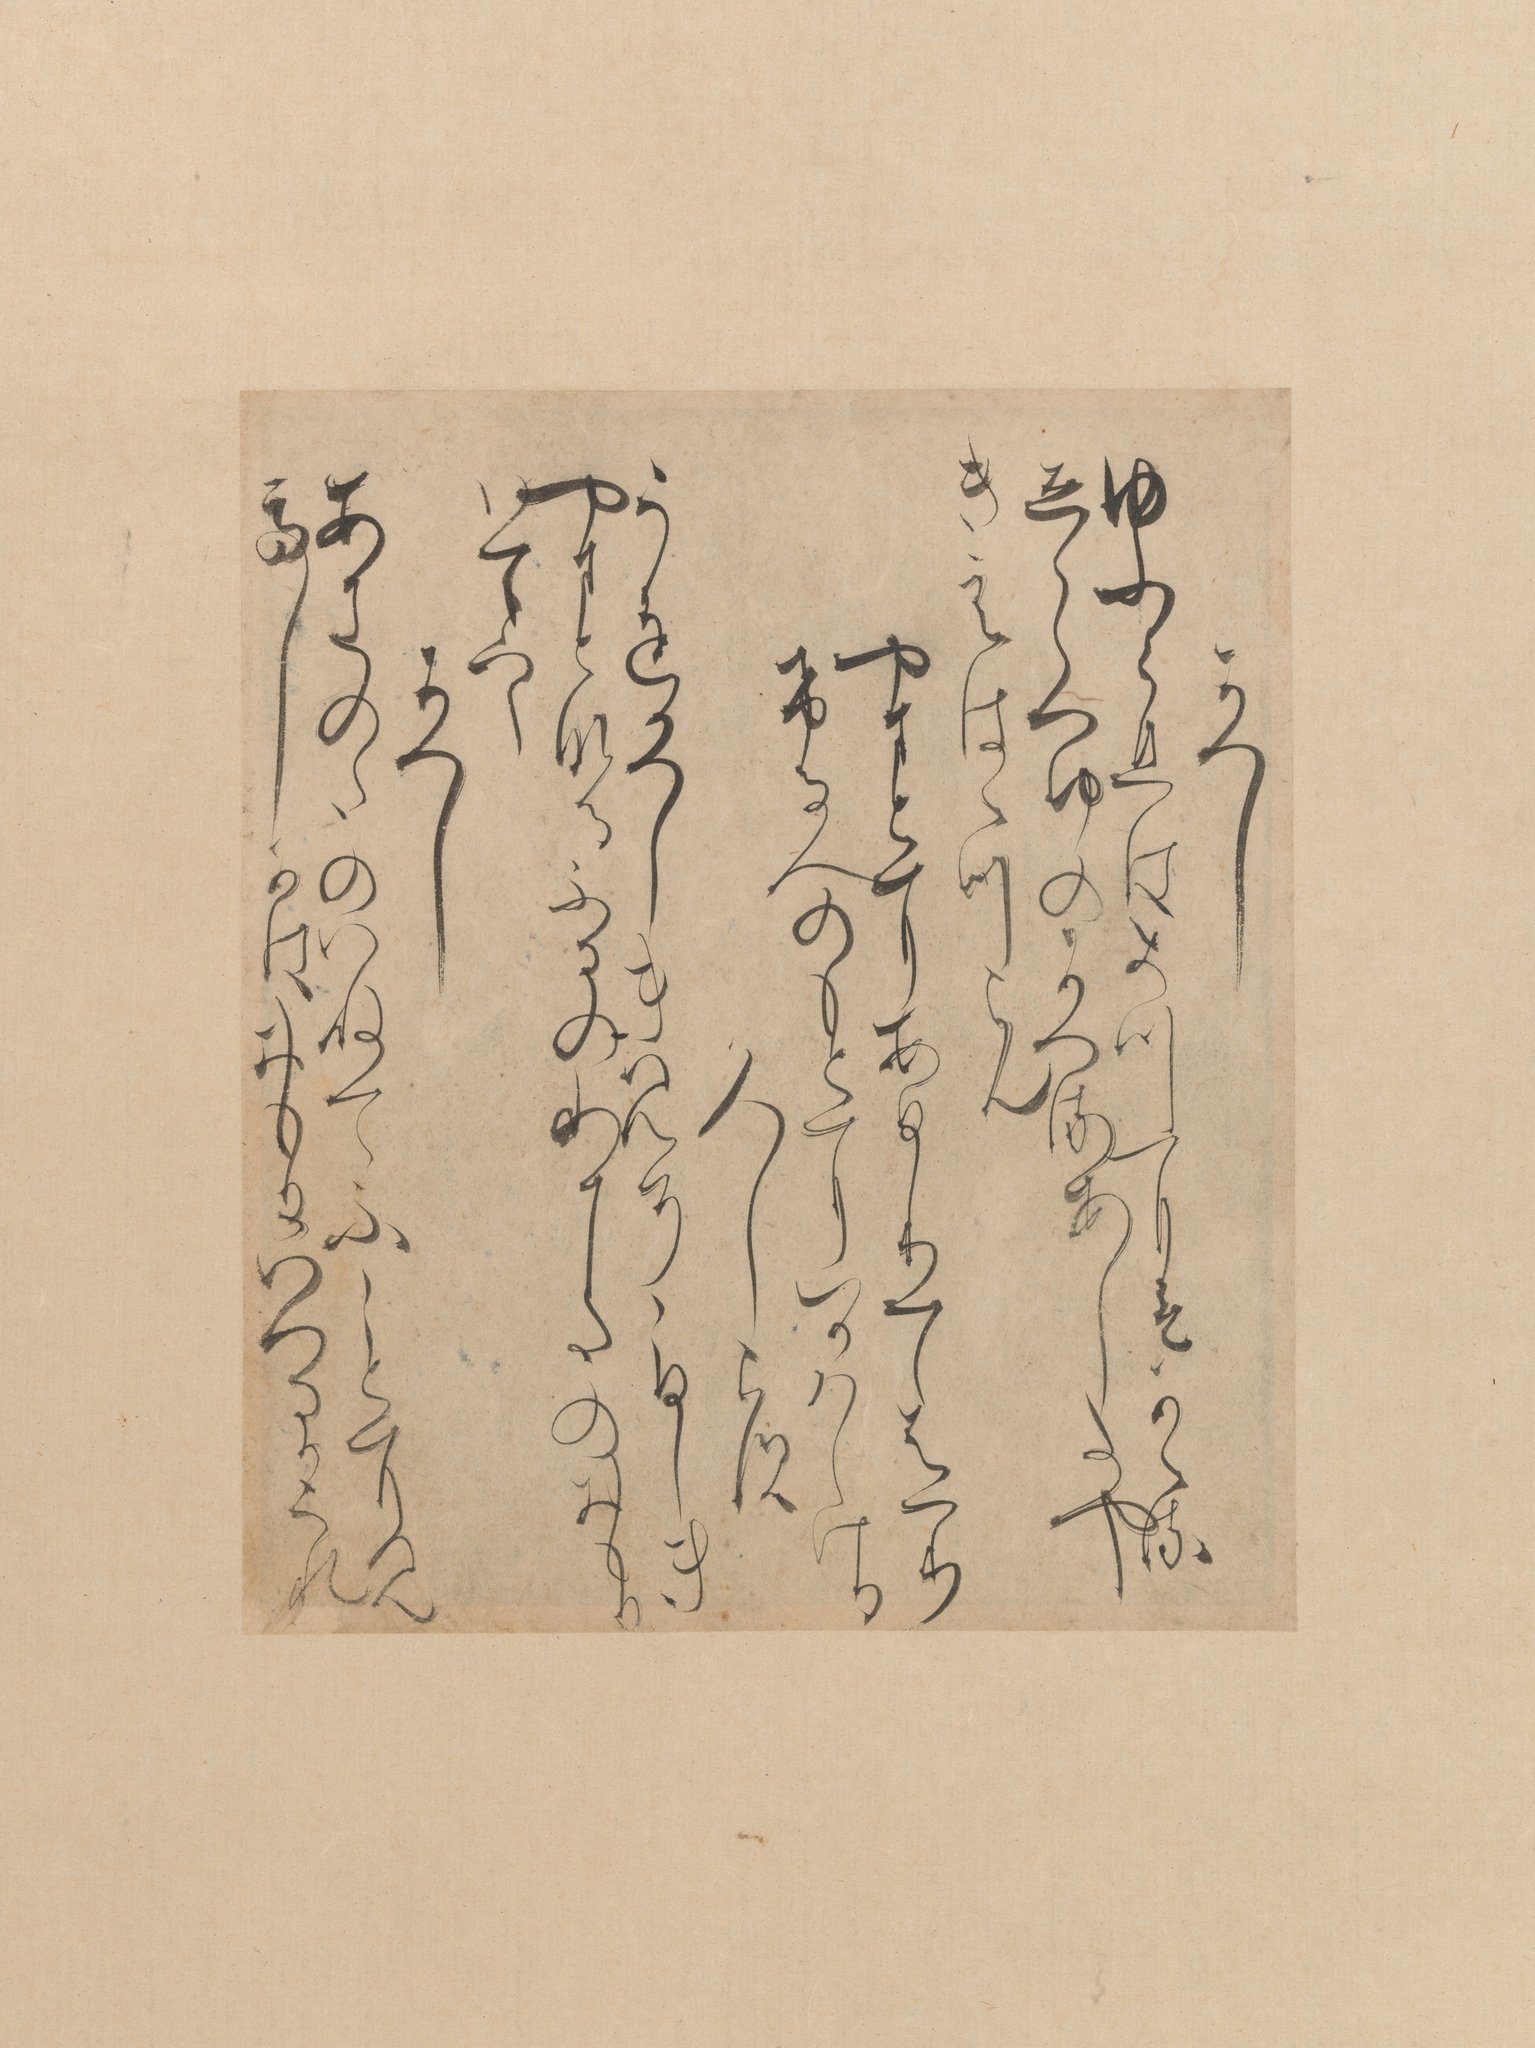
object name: hanging scroll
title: Three Poems from the Later Collection of Japanese Poems (Gosen wakashū)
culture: japanese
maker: monk saigyō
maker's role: artist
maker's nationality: japanese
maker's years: 1118-1190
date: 1167-1200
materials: ink, paper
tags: poetry,scrolls